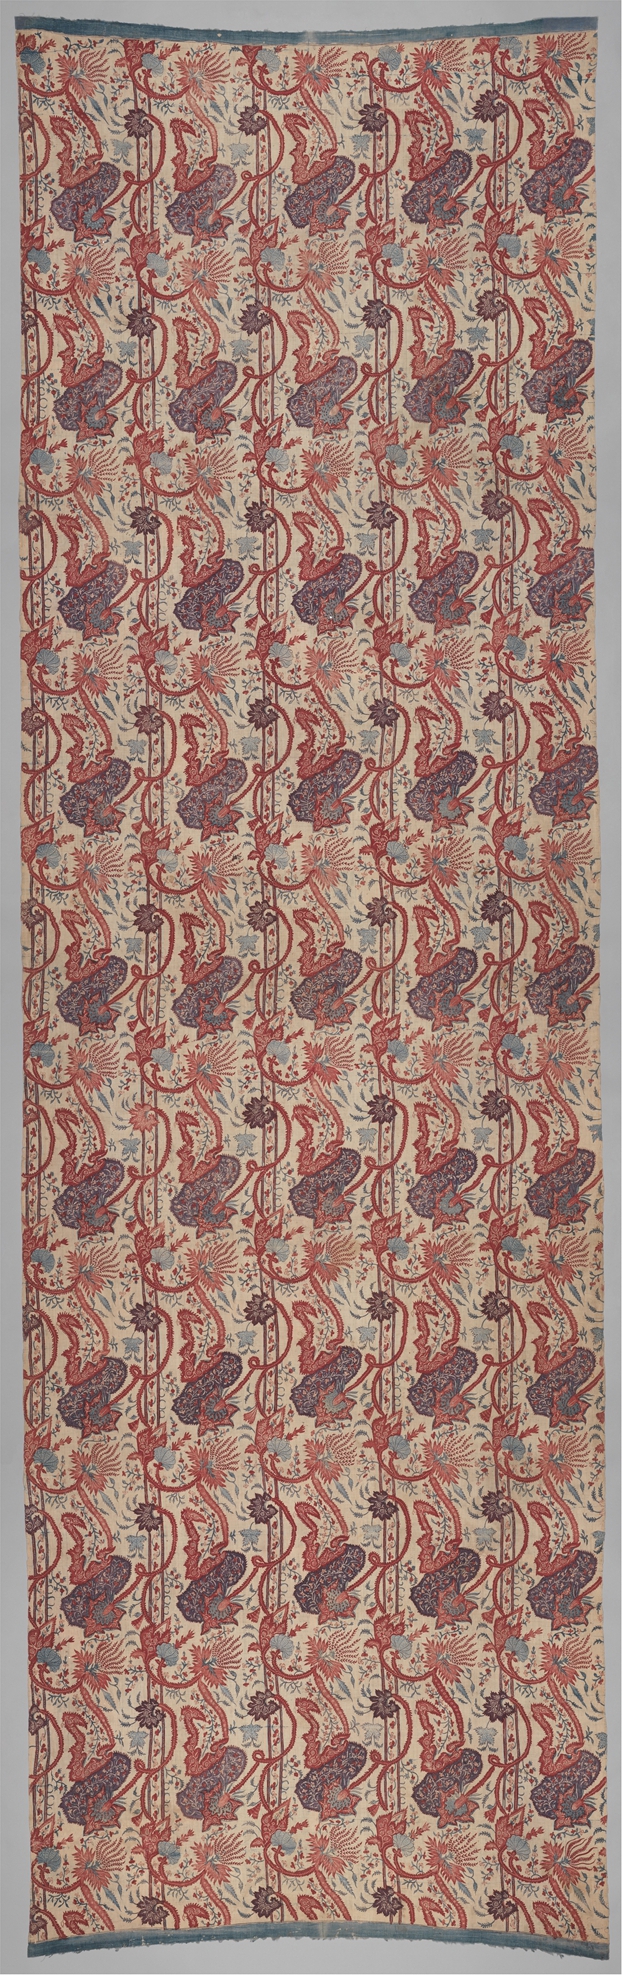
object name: length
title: Length of cotton "chintz"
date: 1701-1725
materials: cotton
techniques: dyeing, painting, resist